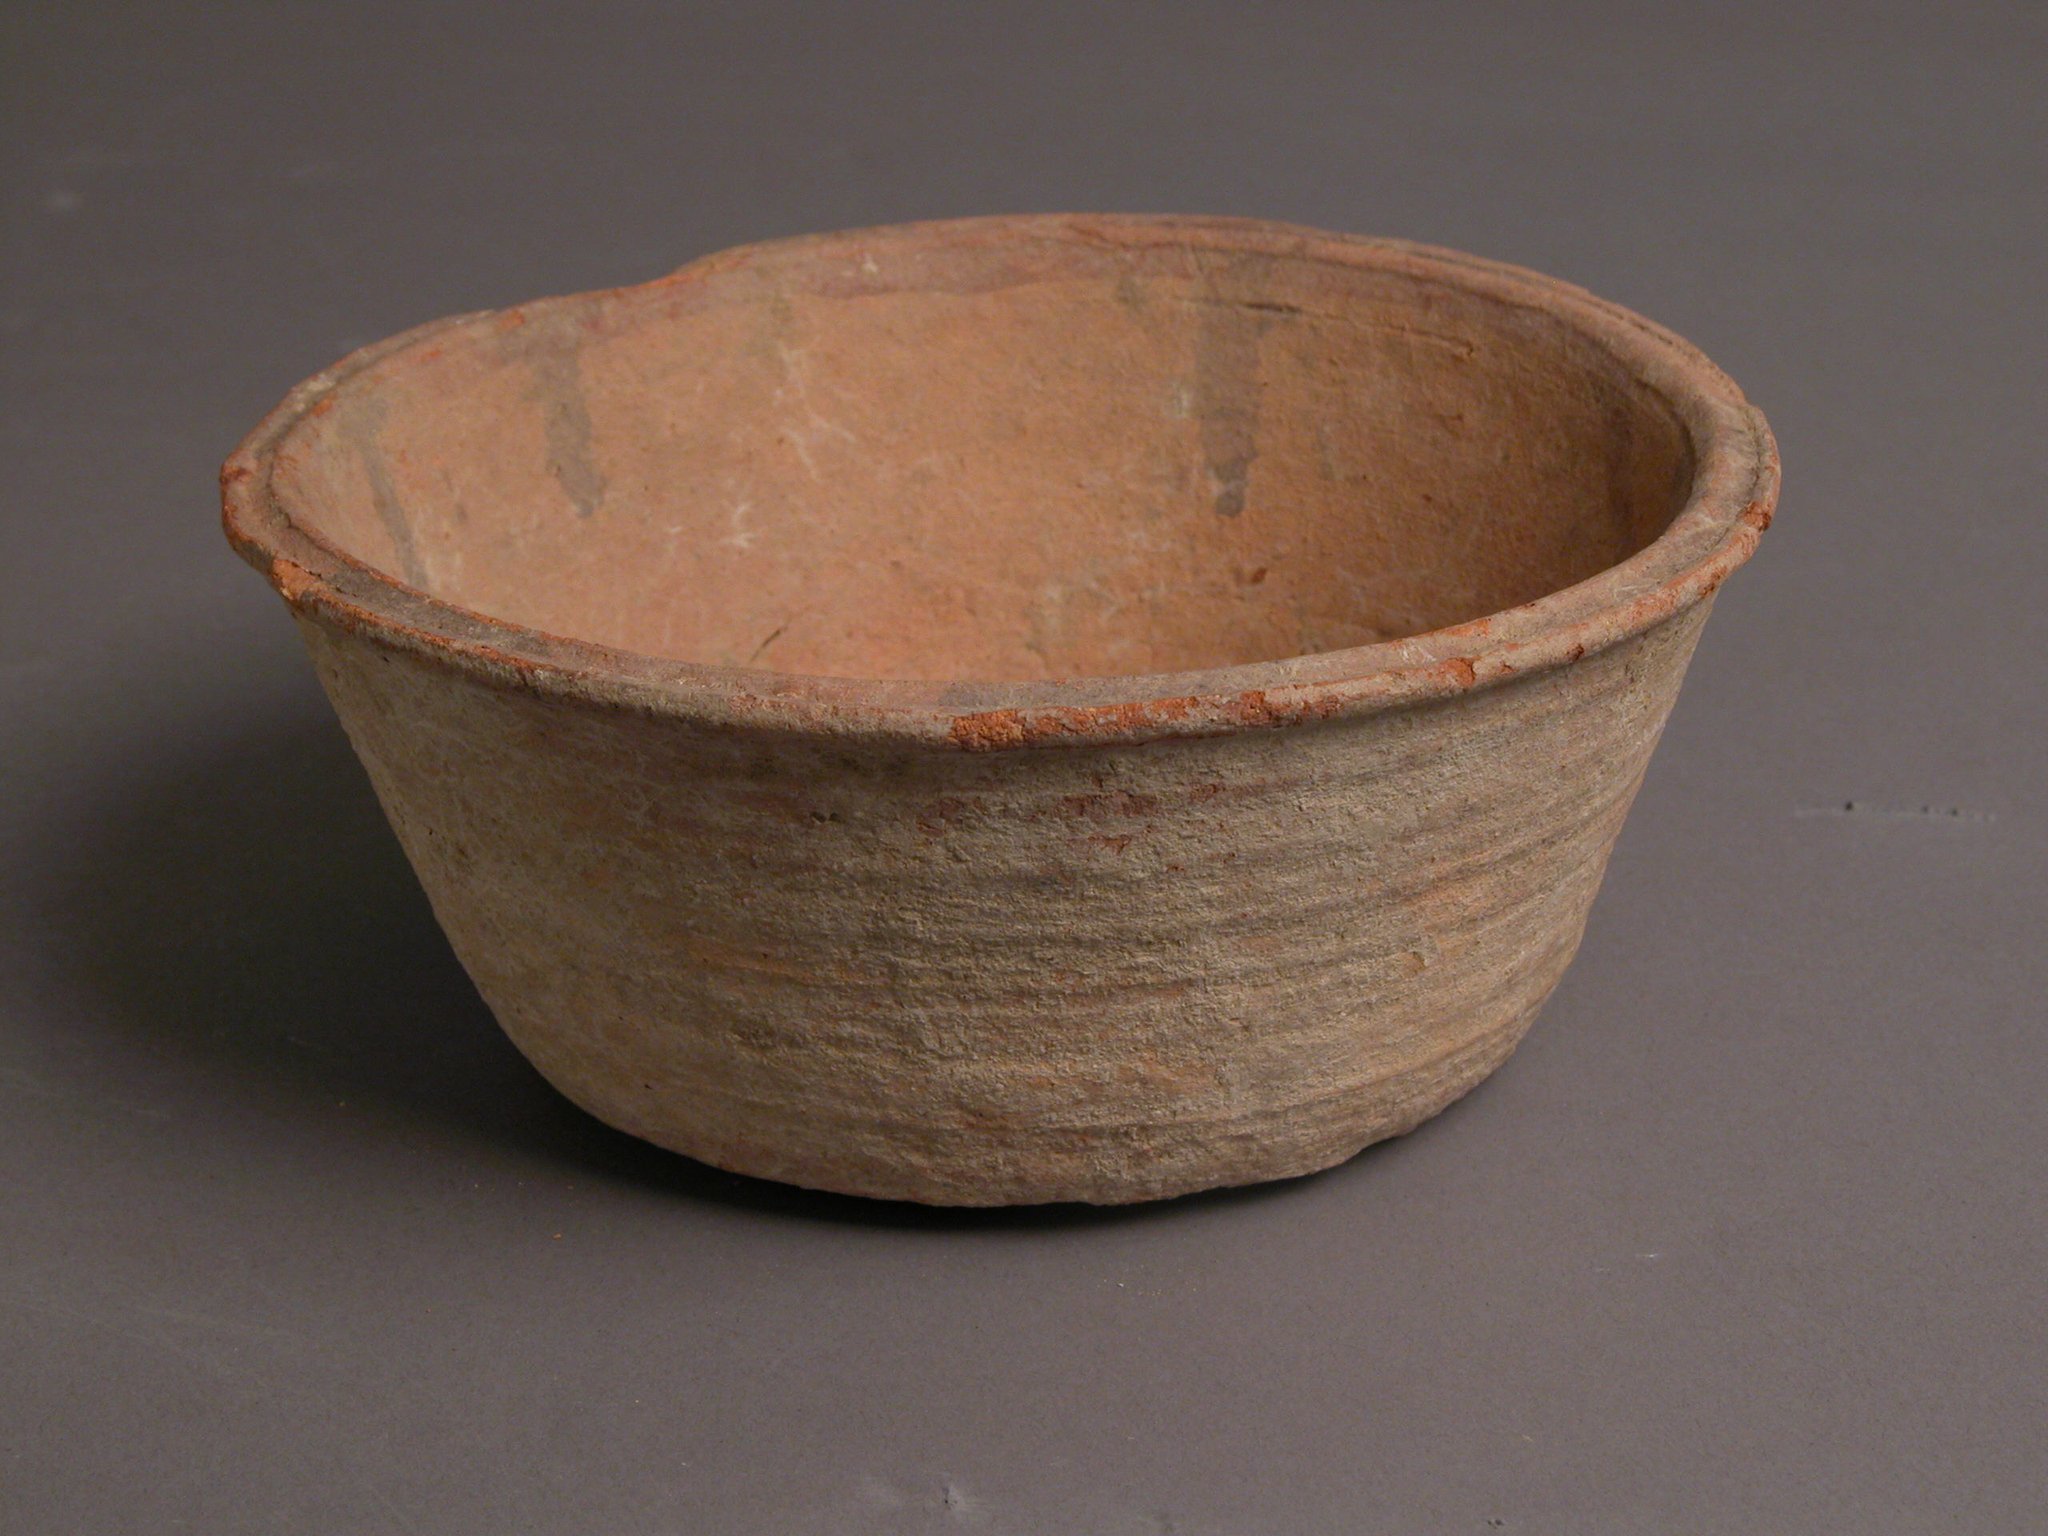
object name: bowl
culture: coptic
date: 301-700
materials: earthenware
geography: egypt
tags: bowls